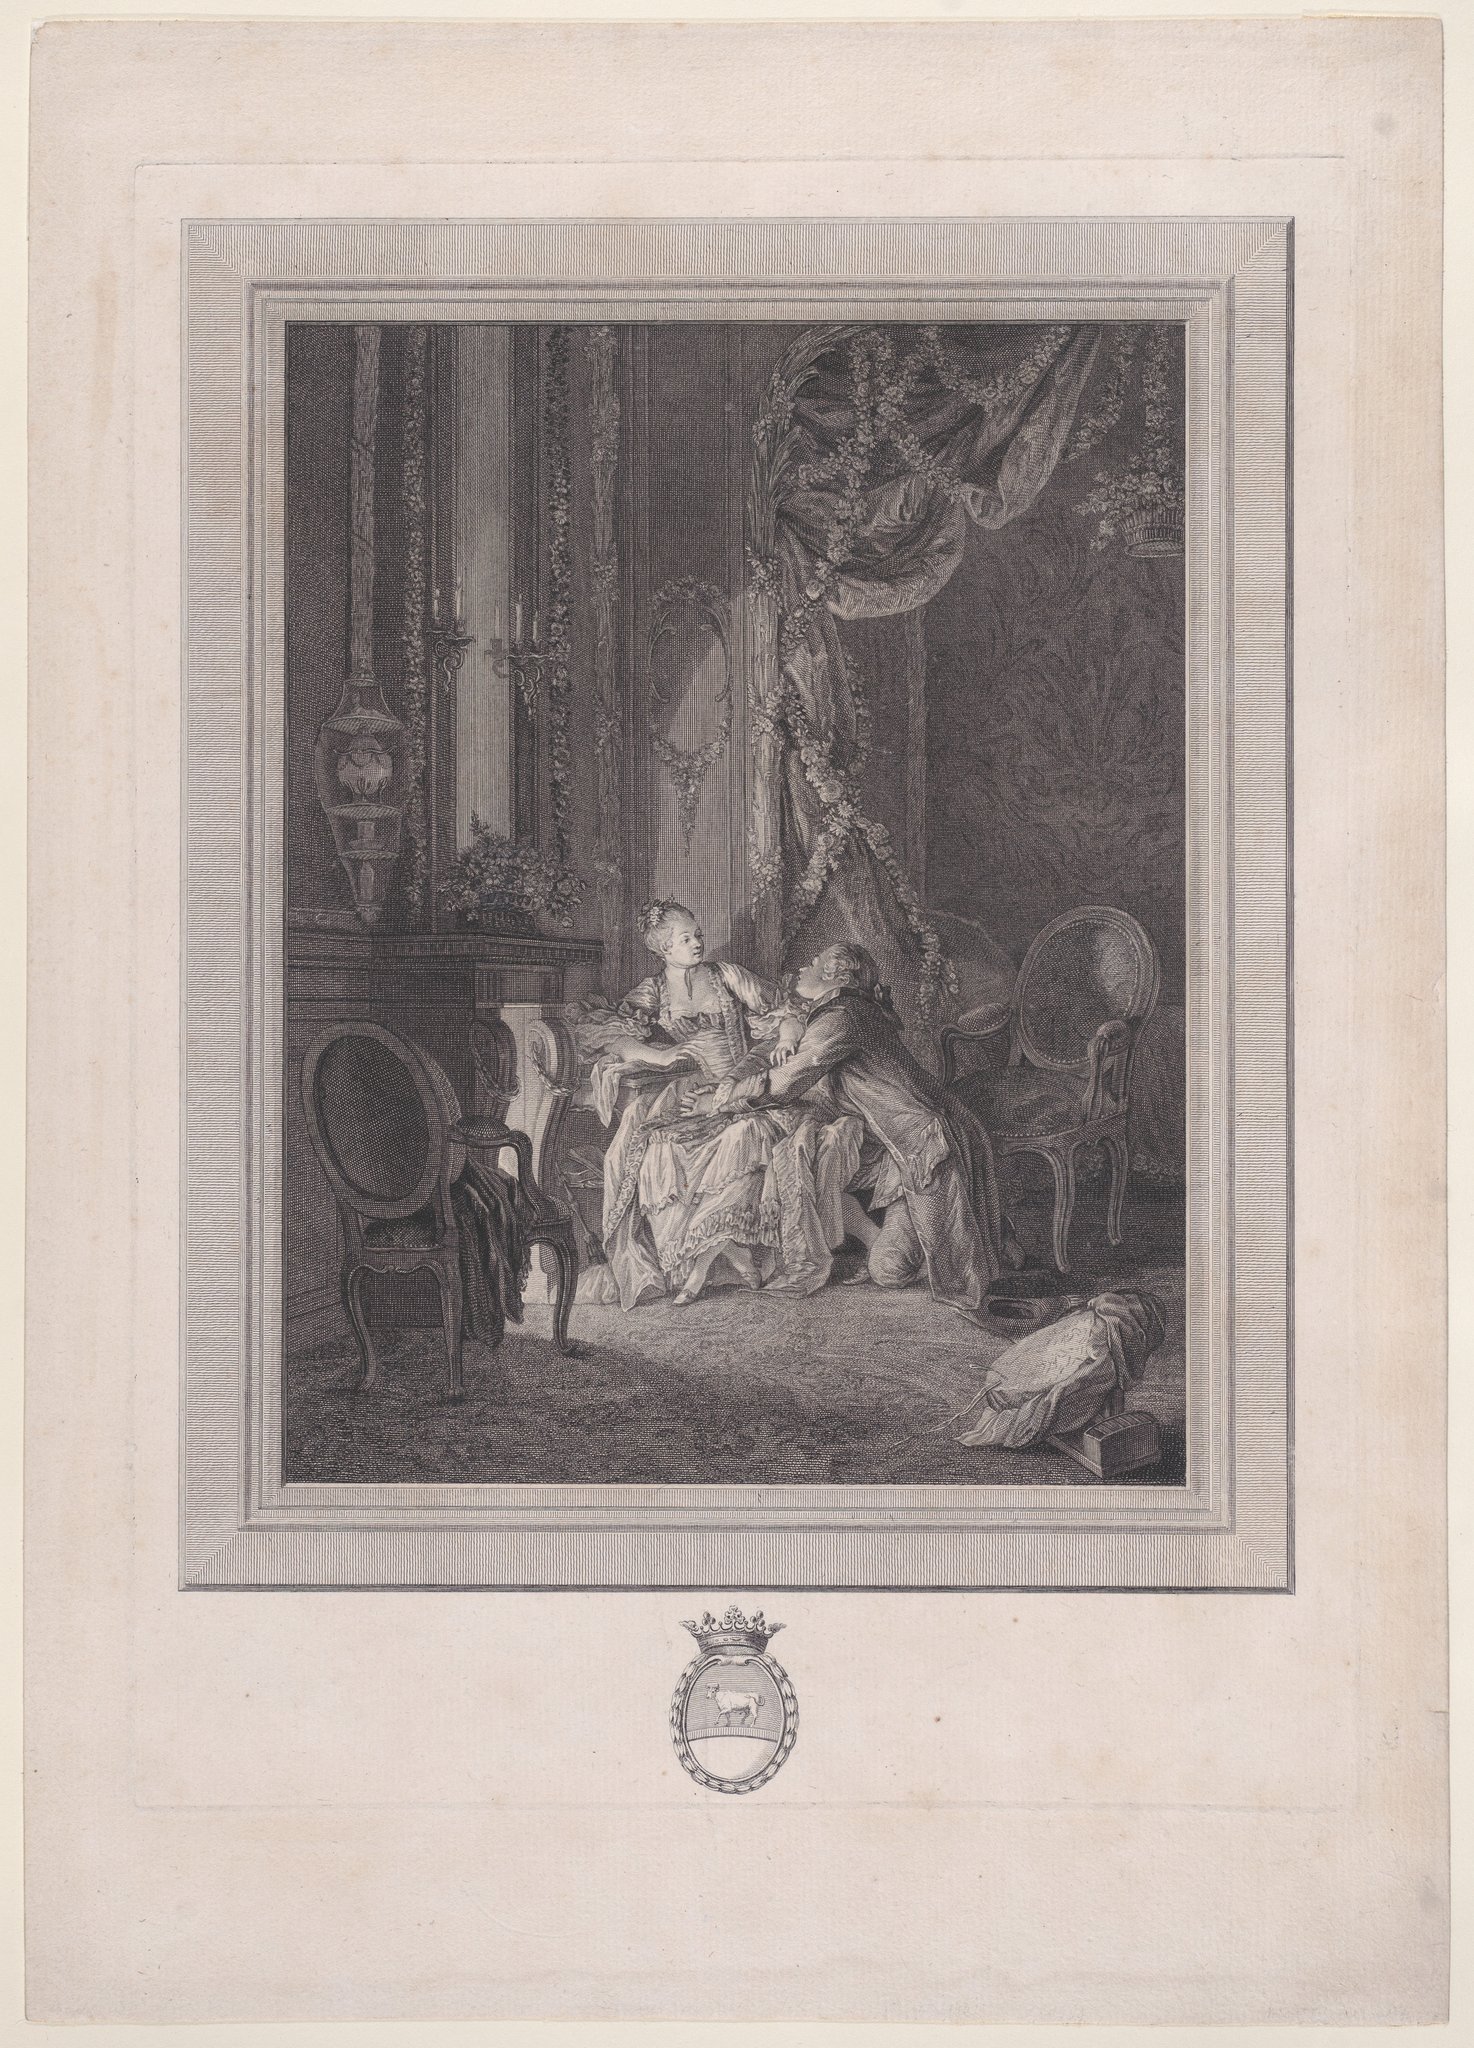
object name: print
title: Le danger du tête-à-tête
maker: pierre antoine baudouin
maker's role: artist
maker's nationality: french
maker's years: 1723-1769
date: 1701-1800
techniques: engraving, etching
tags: men,women